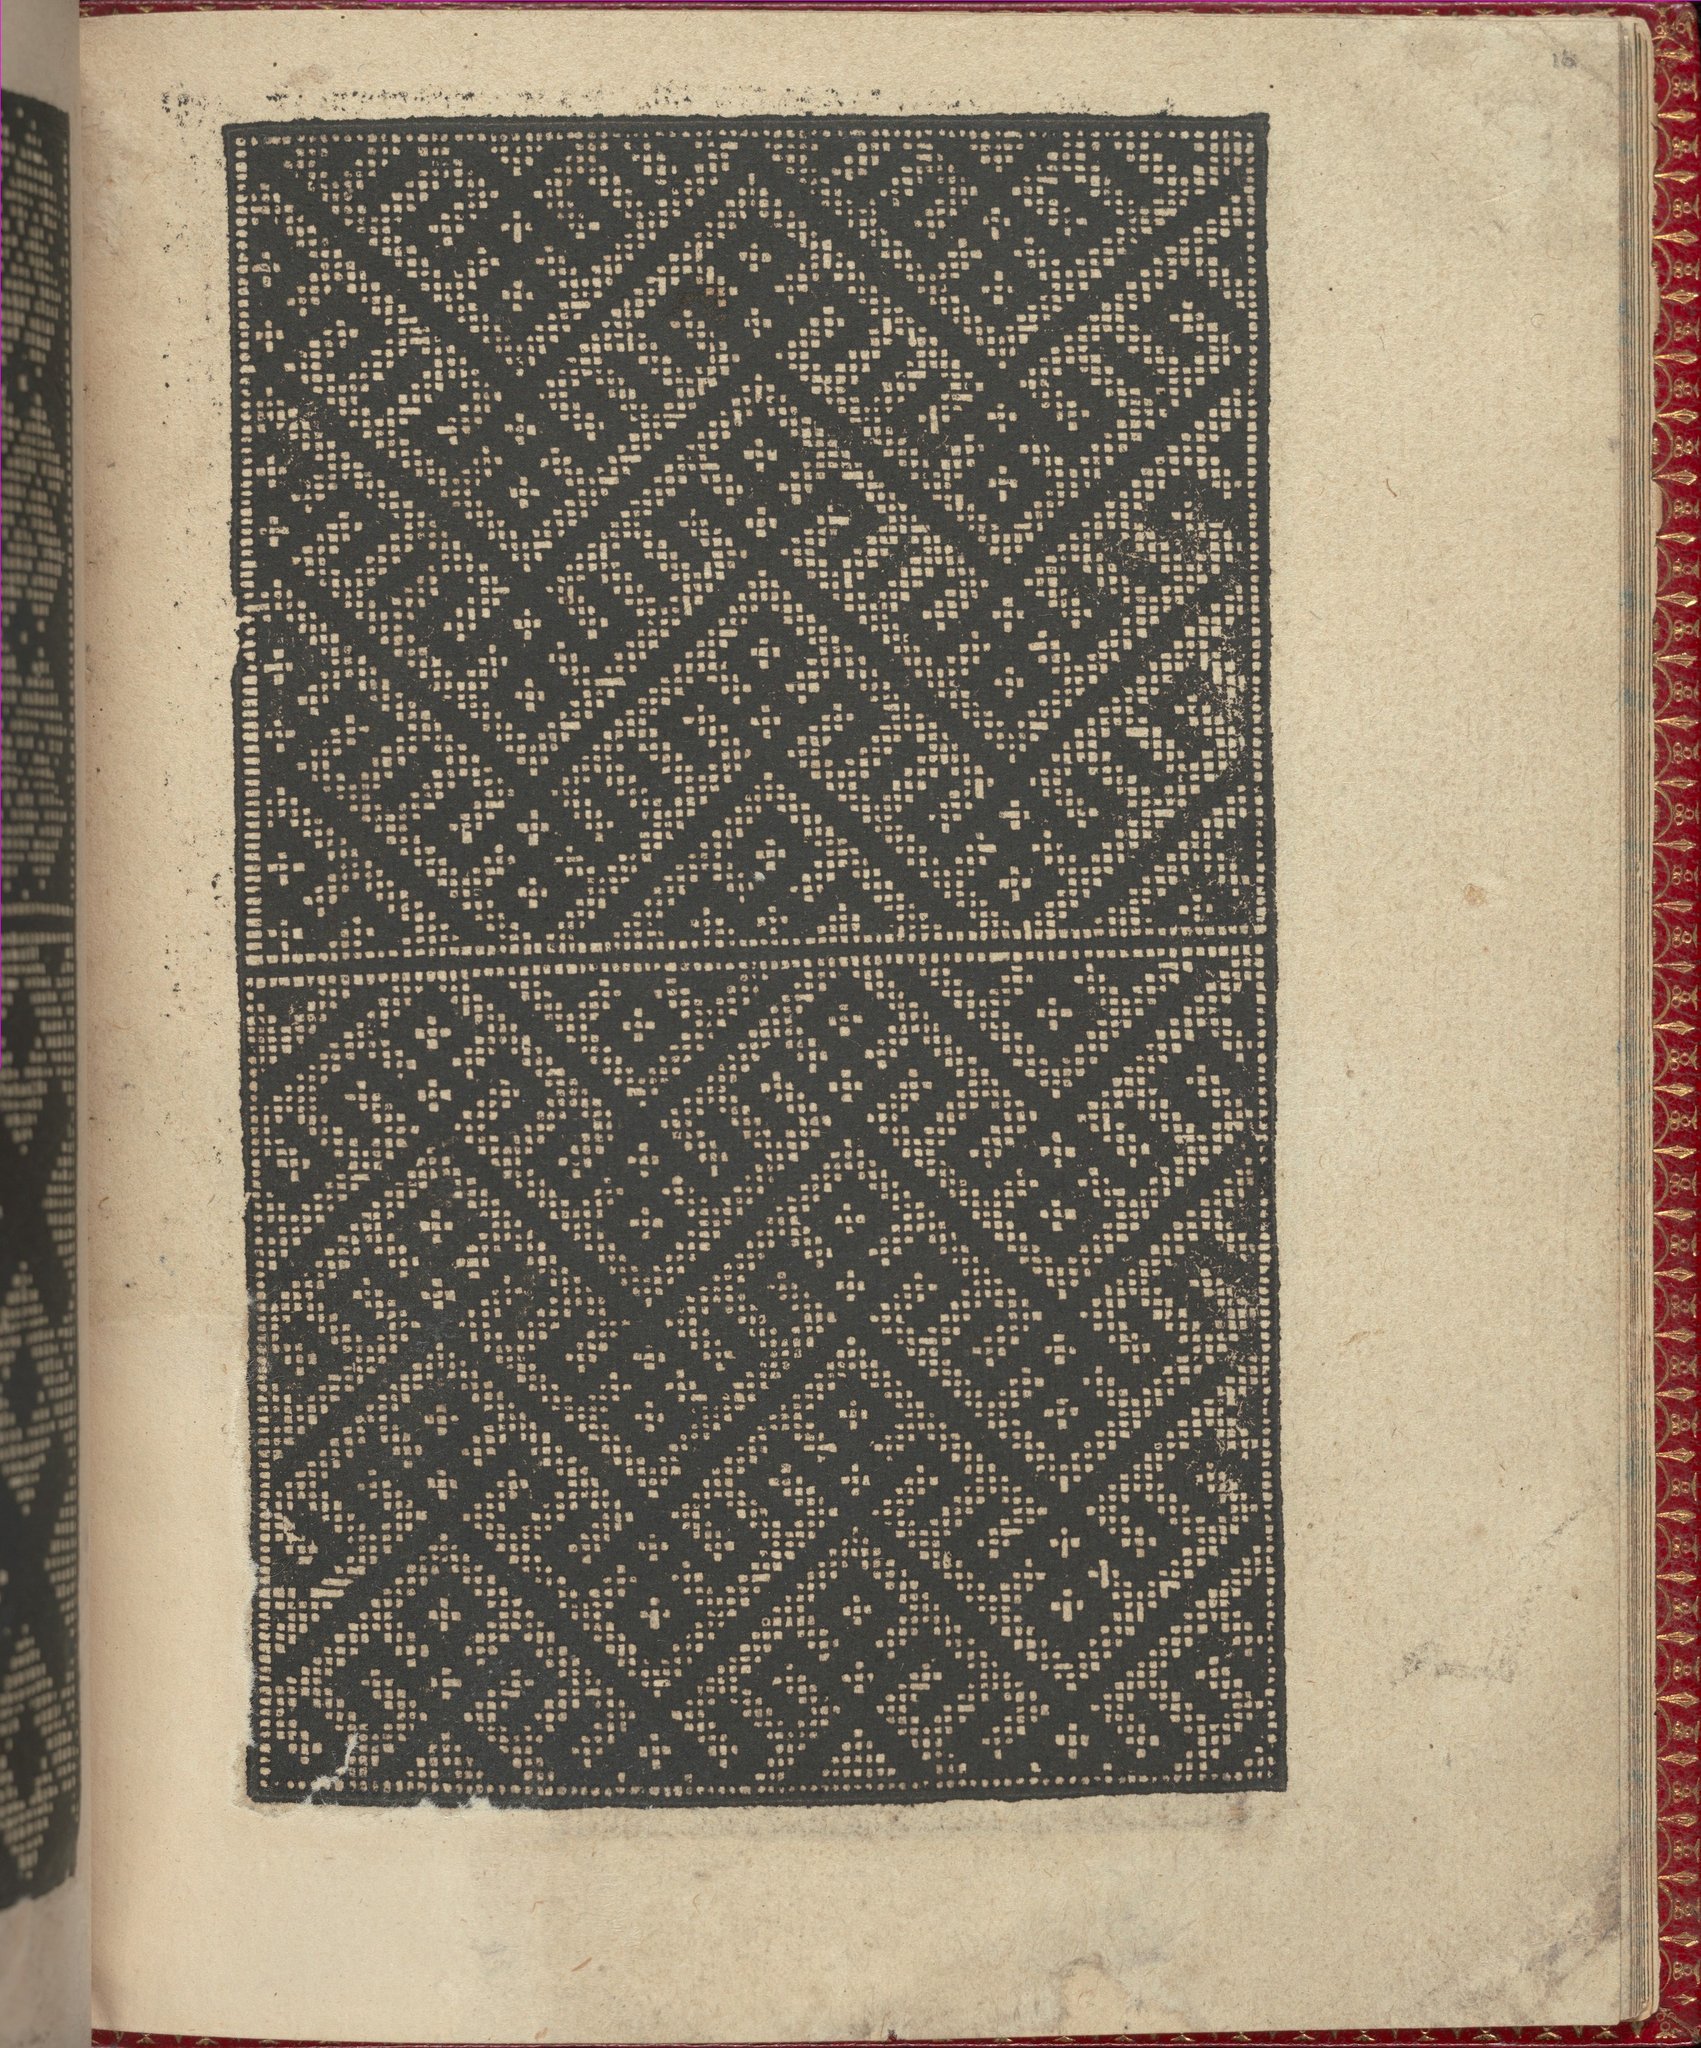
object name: book print ornament architecture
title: Ce est ung tractat de la noble art de leguille ascavoir ouvraiges de spaigne... page 16 (recto)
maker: willem vosterman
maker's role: printer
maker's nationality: netherlandish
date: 1527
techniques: woodcut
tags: ornament